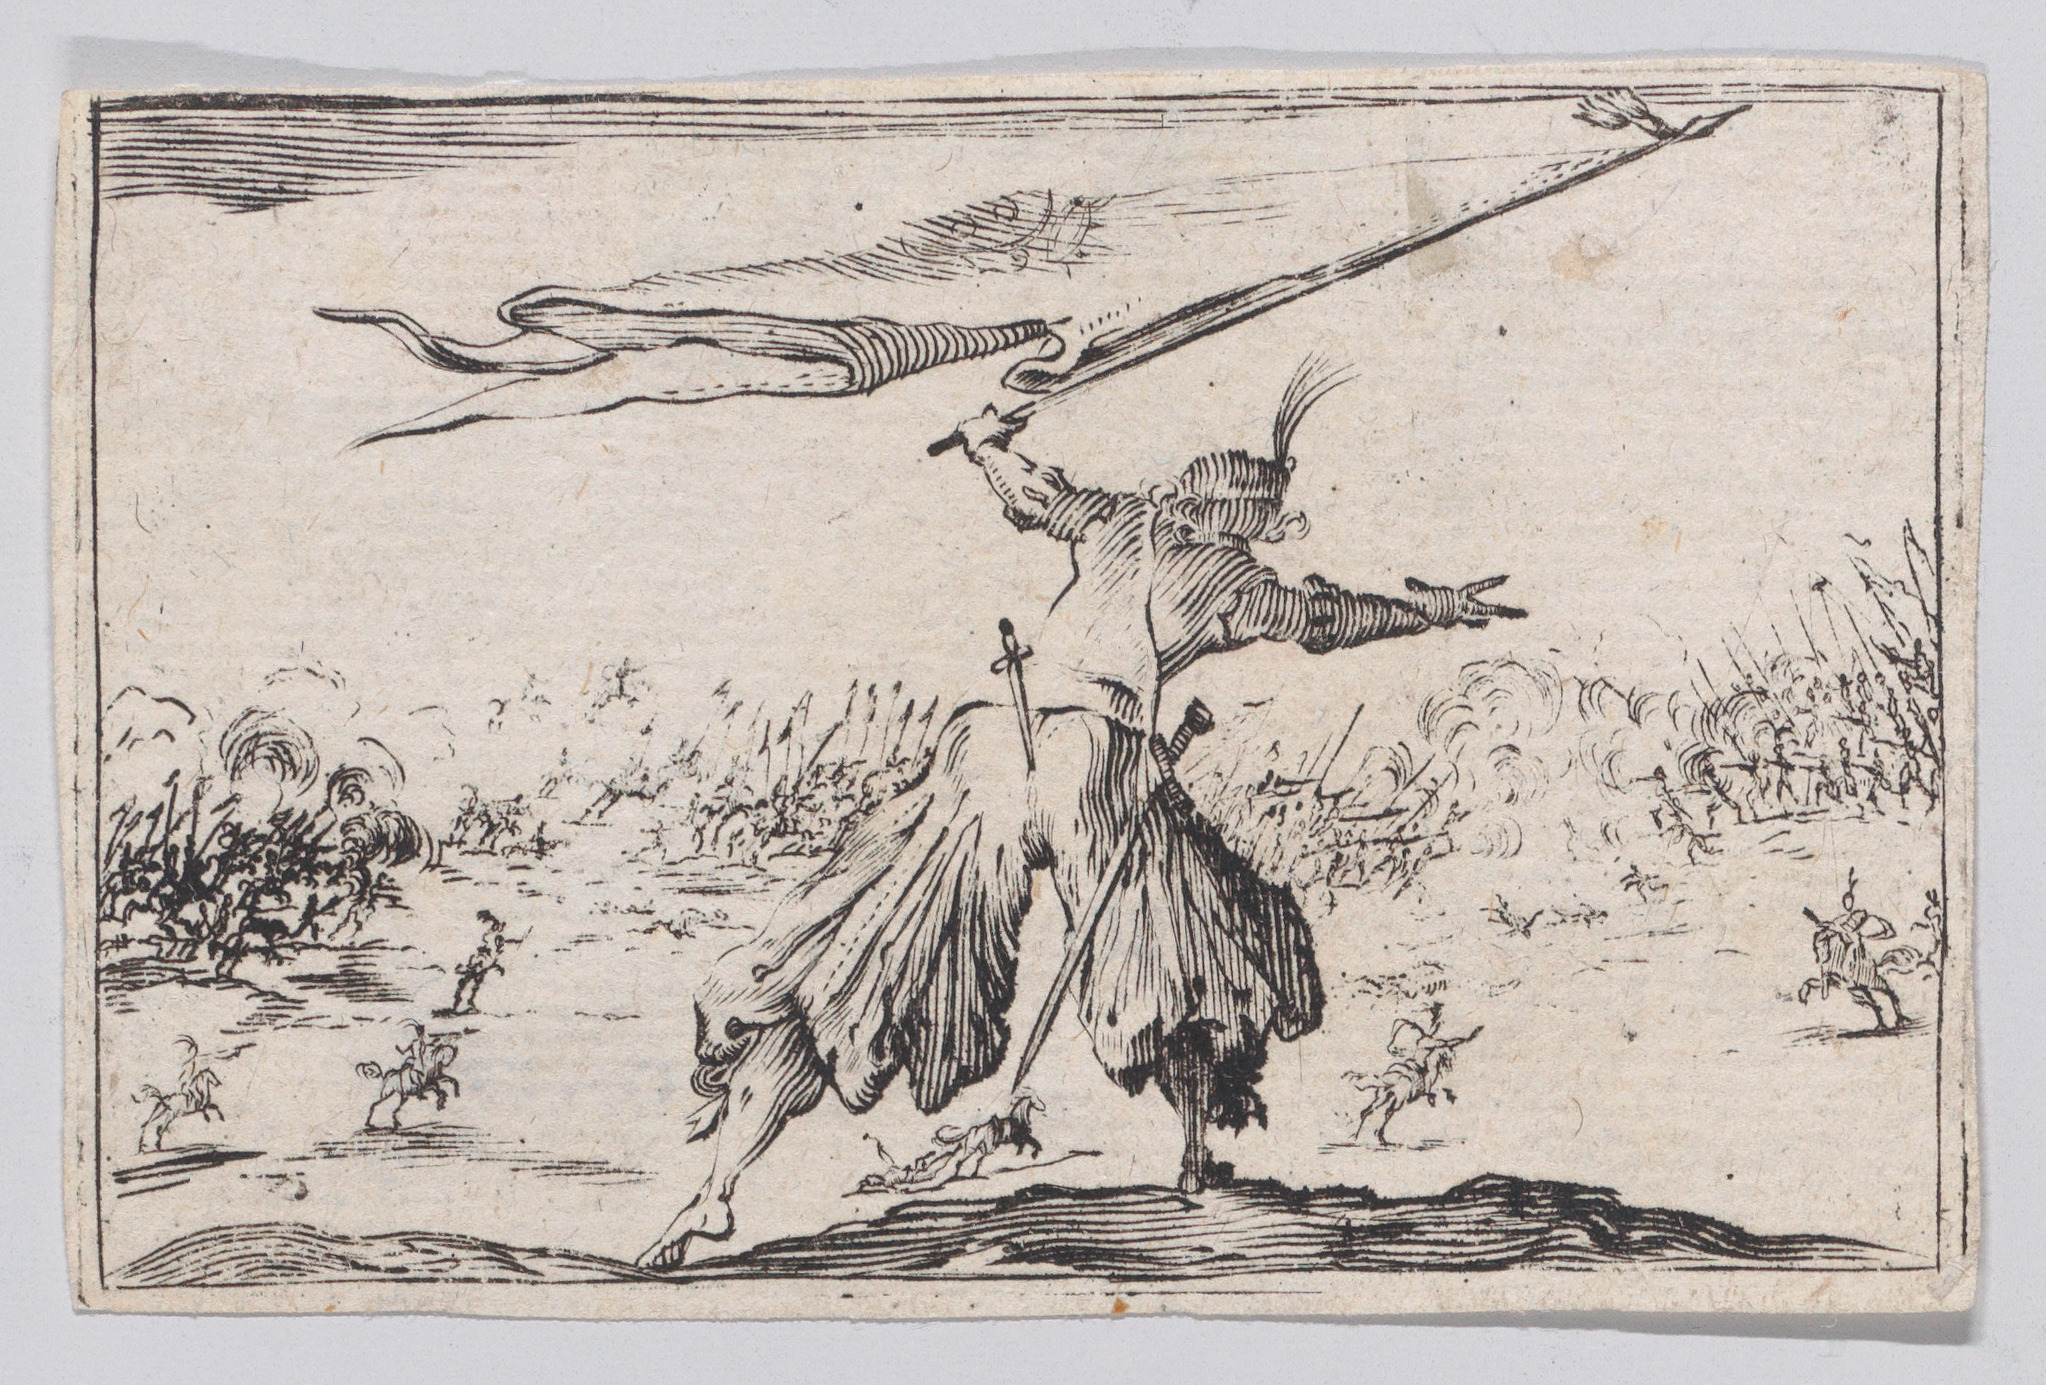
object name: print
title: Reverse Copy of Le Porte-Étendard (The Standard Bearer), from Les Caprices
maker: Anonymous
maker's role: artist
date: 1601-1700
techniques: etching